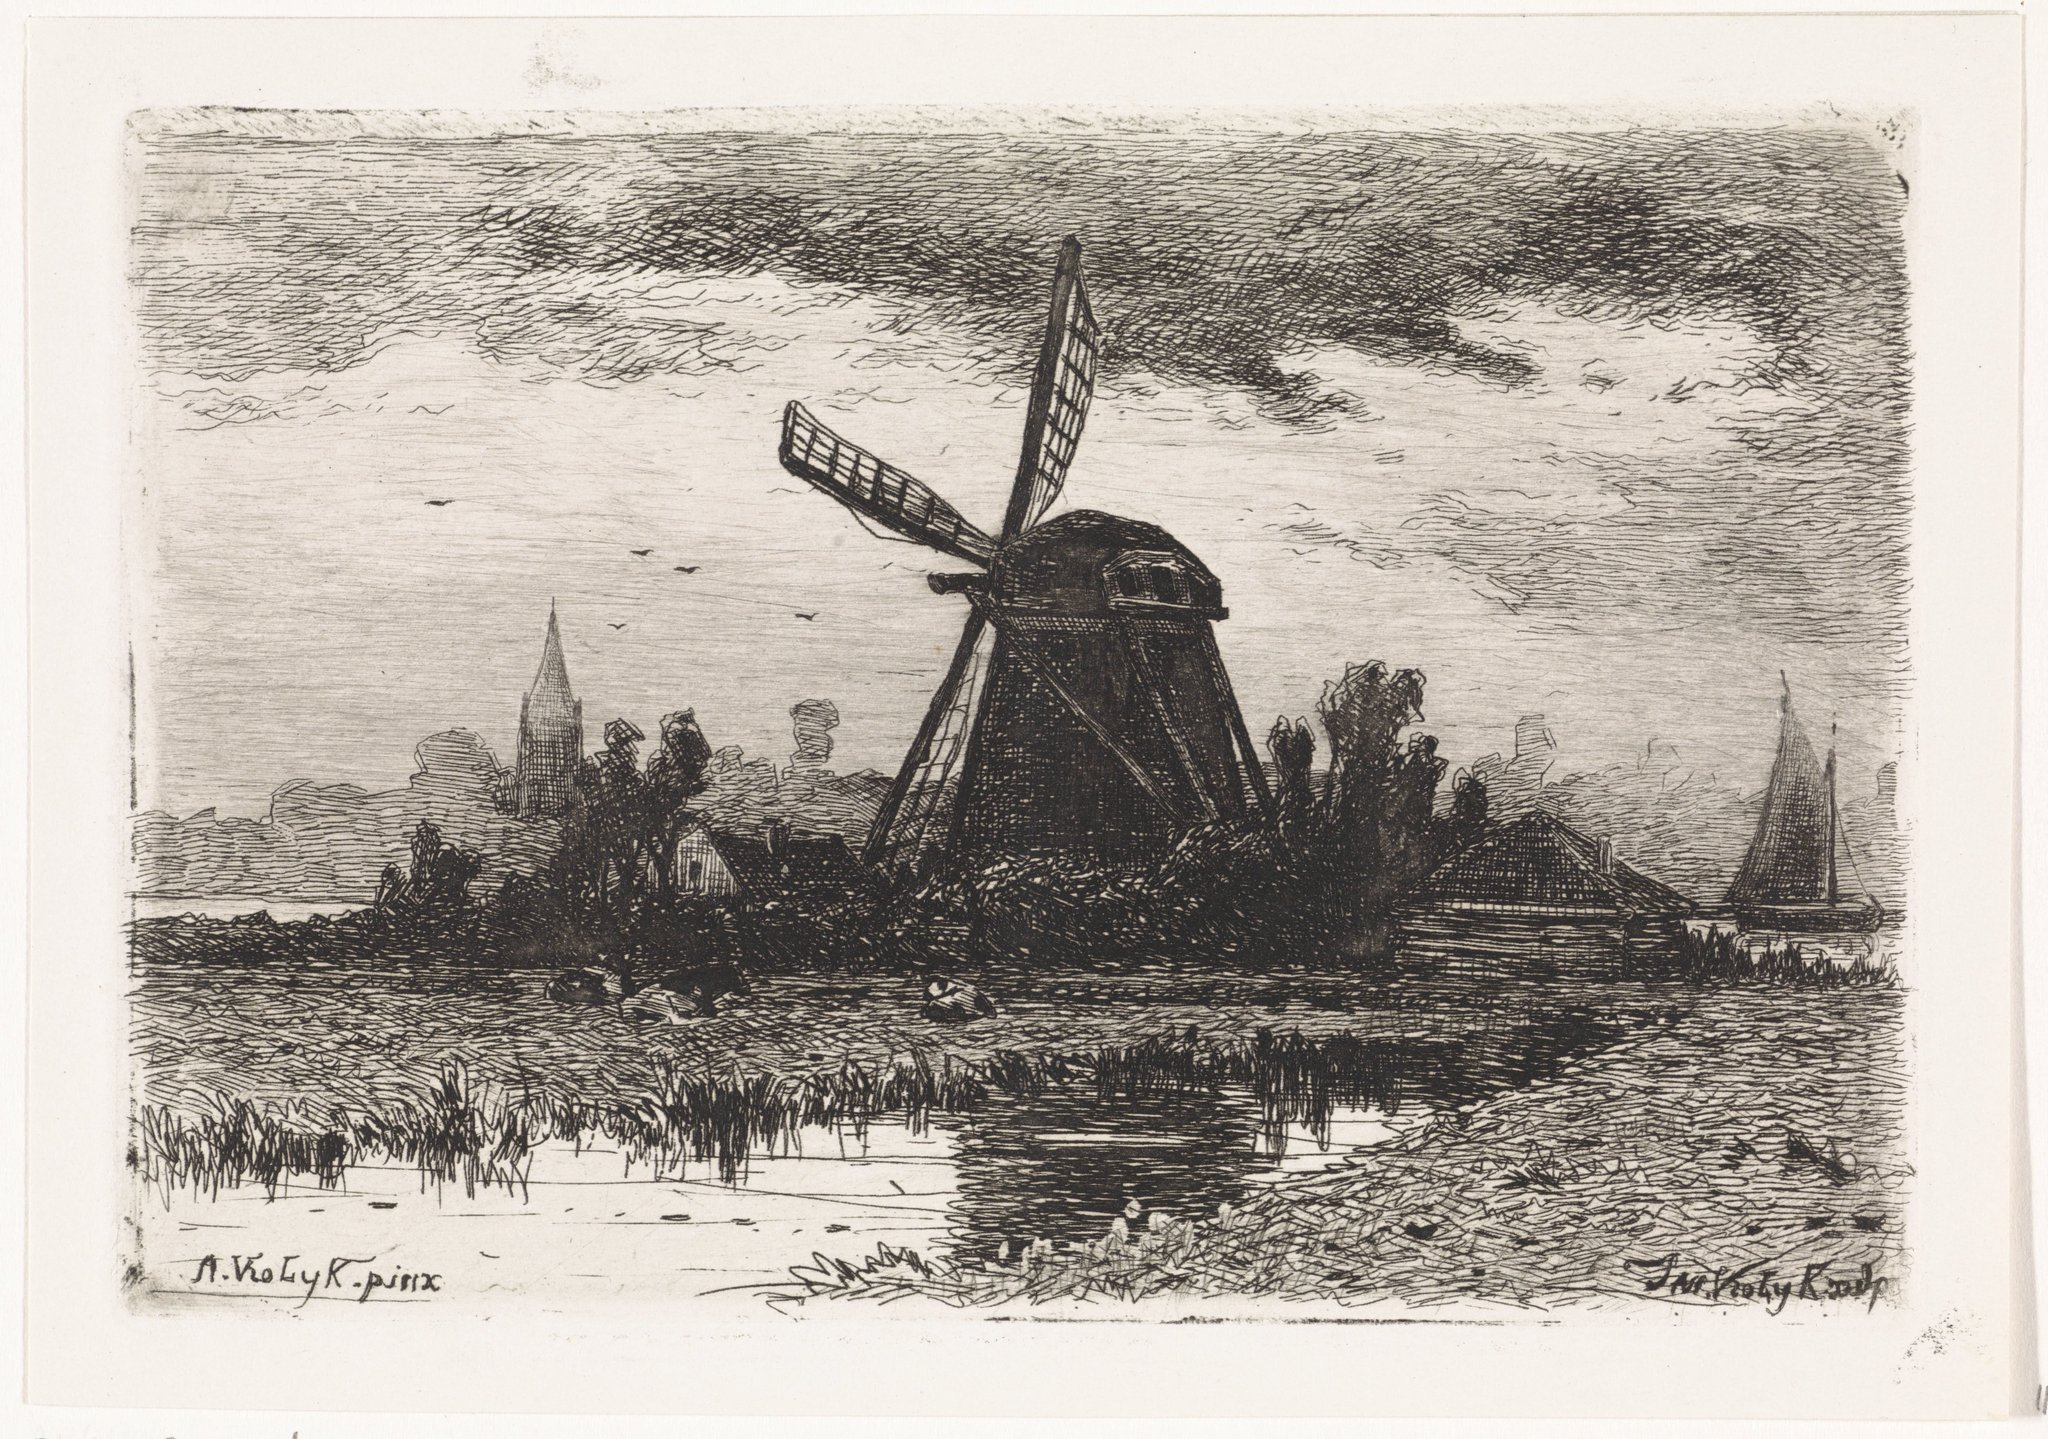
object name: print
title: Landschap met molen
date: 1860-1883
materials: paper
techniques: etching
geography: the hague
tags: windmill in landscape, small canal, ditch, parts of church exterior and annexes: tower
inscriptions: collector's mark: Lugt 2228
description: Gezicht op een molen, aan de rand van een weiland. Water op de voorgrond. Op de achtergrond een kerktoren.